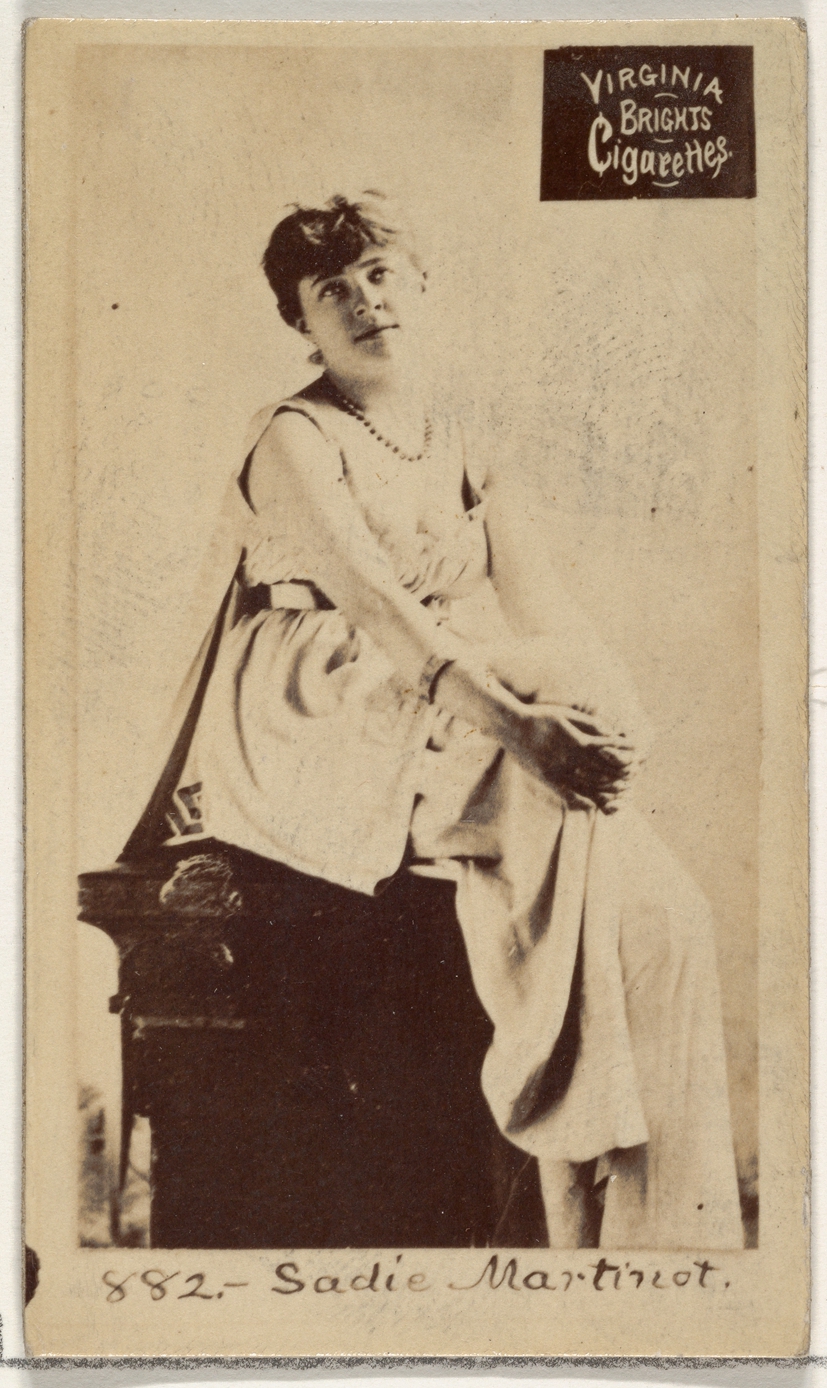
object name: photograph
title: Card 882, Sadie Martinot, from the Actors and Actresses series (N45, Type 2) for Virginia Brights Cigarettes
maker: allen & ginter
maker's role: publisher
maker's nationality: american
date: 1888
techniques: albumen silver print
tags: portraits,women,actresses